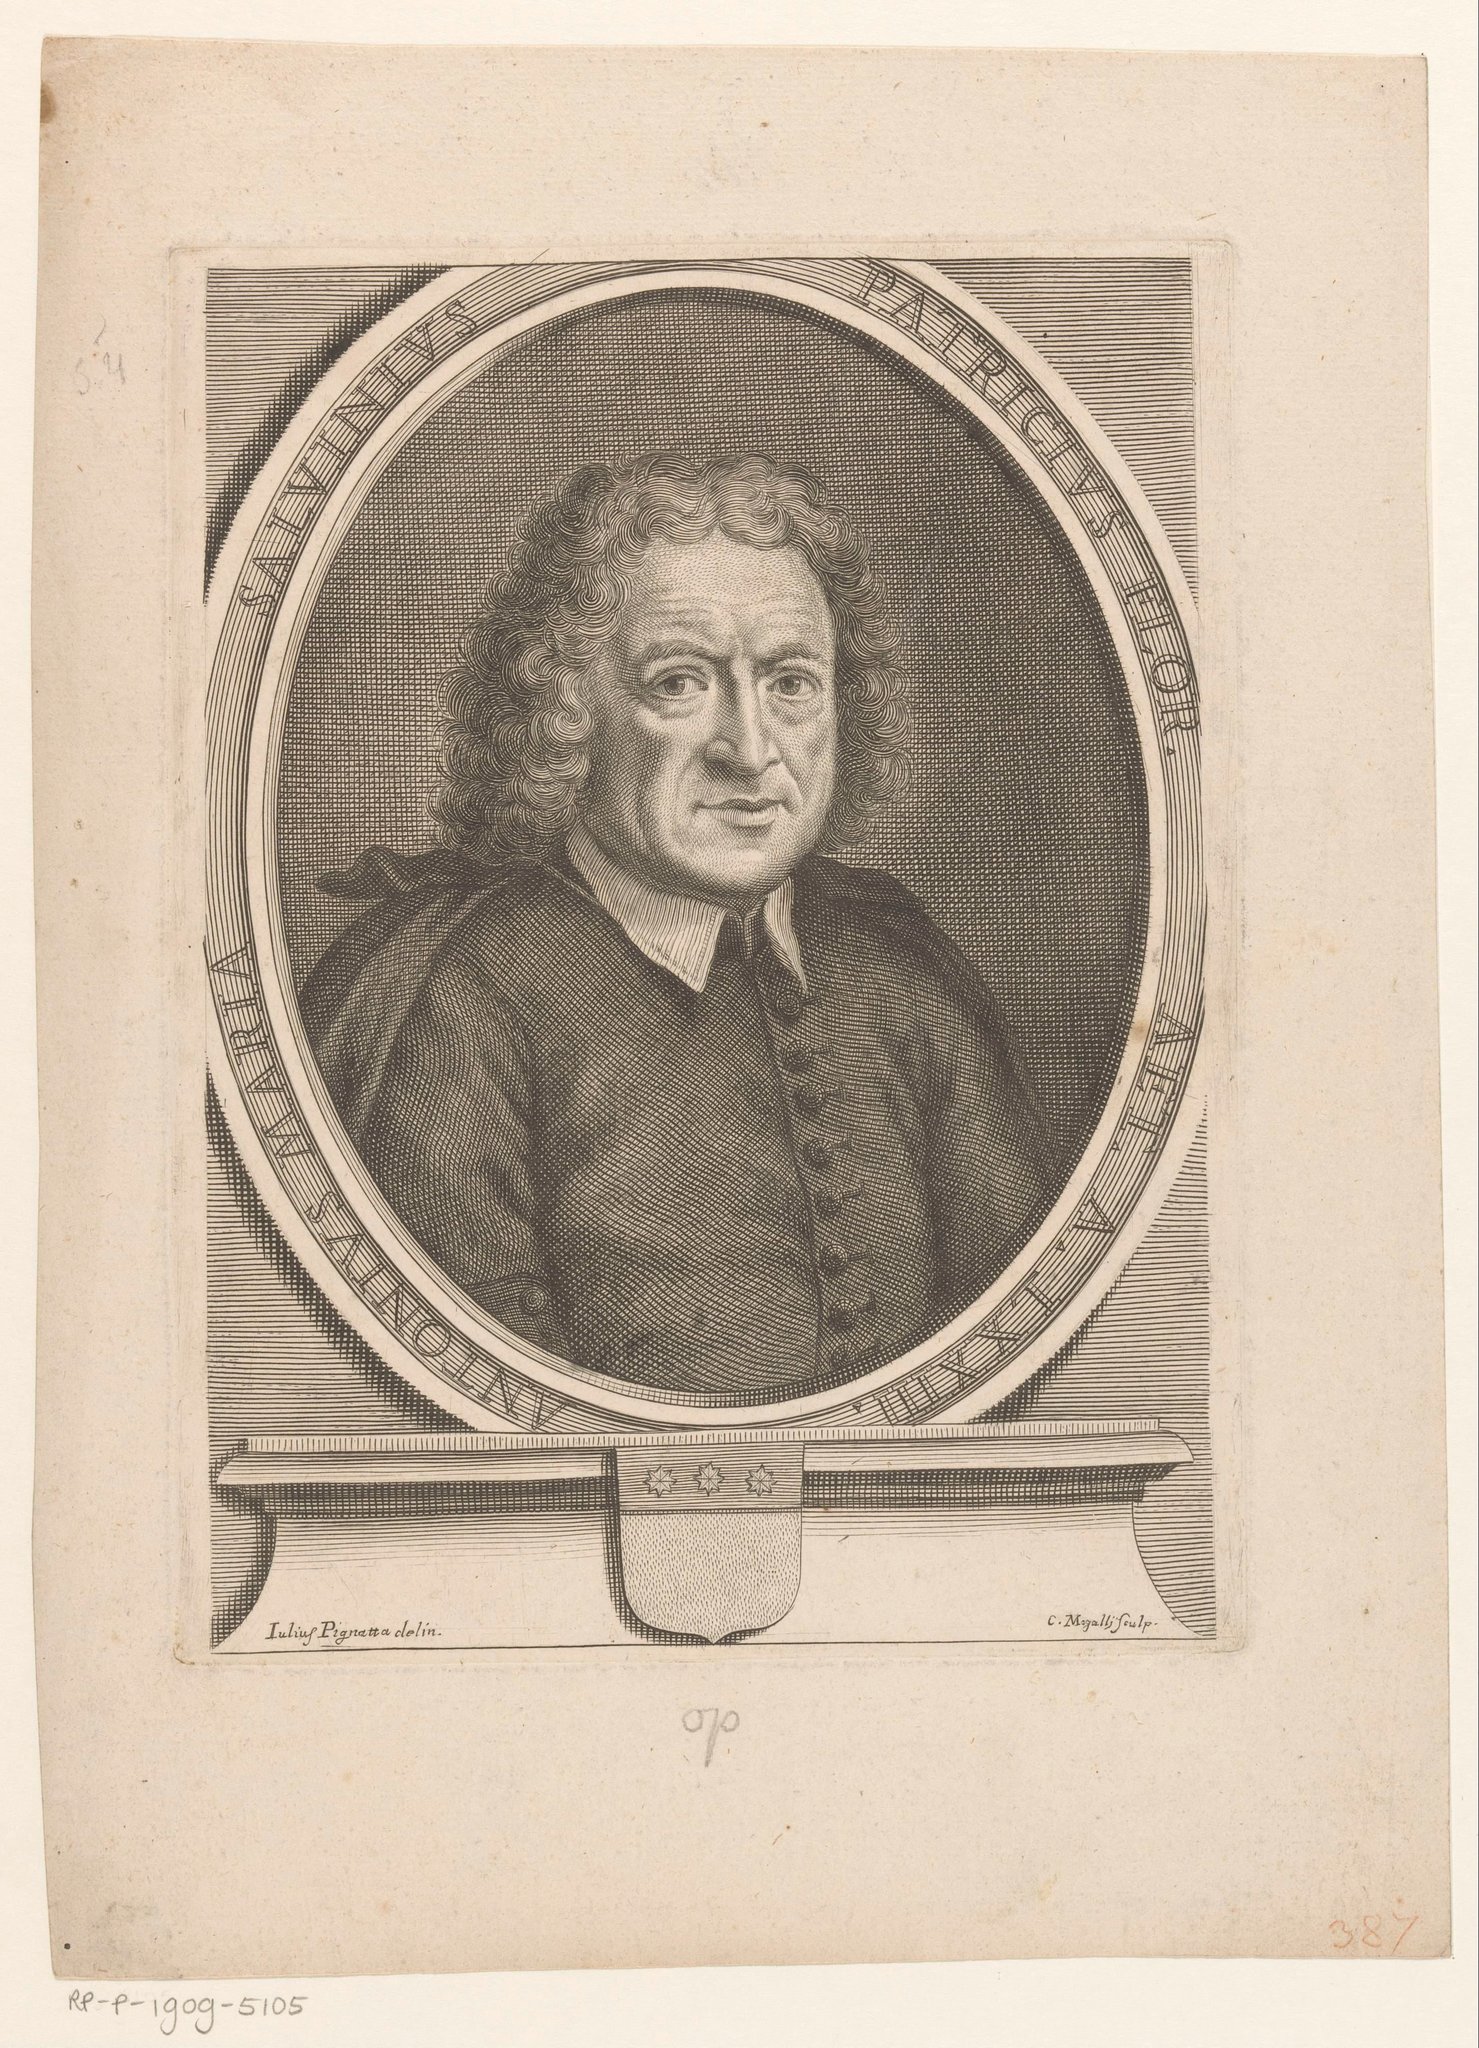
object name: print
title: Portret van hellenist Anton Maria Salvini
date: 1677-1730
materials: paper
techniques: engraving, etching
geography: italy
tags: anton maria salvini, historical persons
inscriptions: collector's mark: Lugt 2710, collector's mark: Lugt 2228